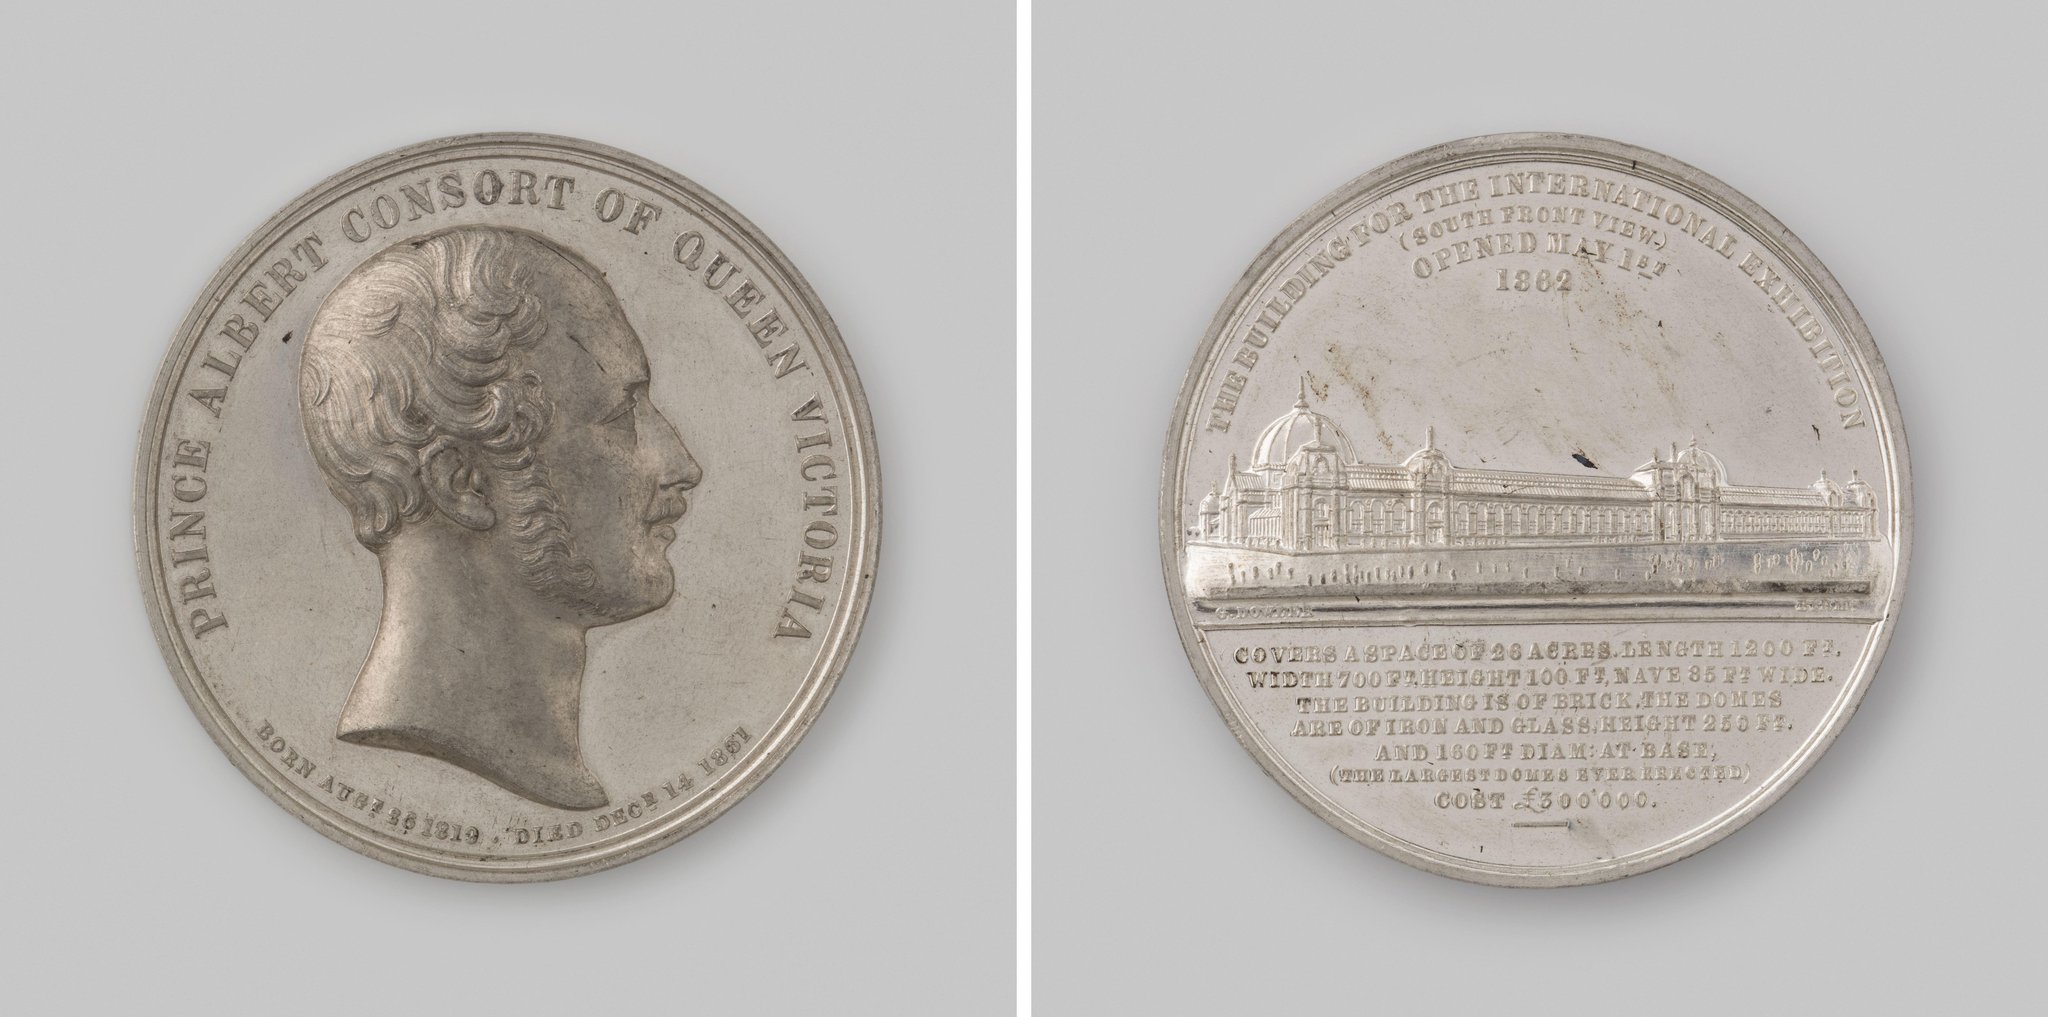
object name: history medal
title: Opening van het tentoonstellingsgebouw van Crystal Palace te Sydenham 1862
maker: george dowler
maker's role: modelleur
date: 1862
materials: tin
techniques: striking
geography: birmingham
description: Tinnen penning, op de voorzijde het portret van Prins Albert naar rechts met omschrift, op de keerzijde vier regels tekst, het tentoonstellingsgebouw en zeven regels afsnedetekst.